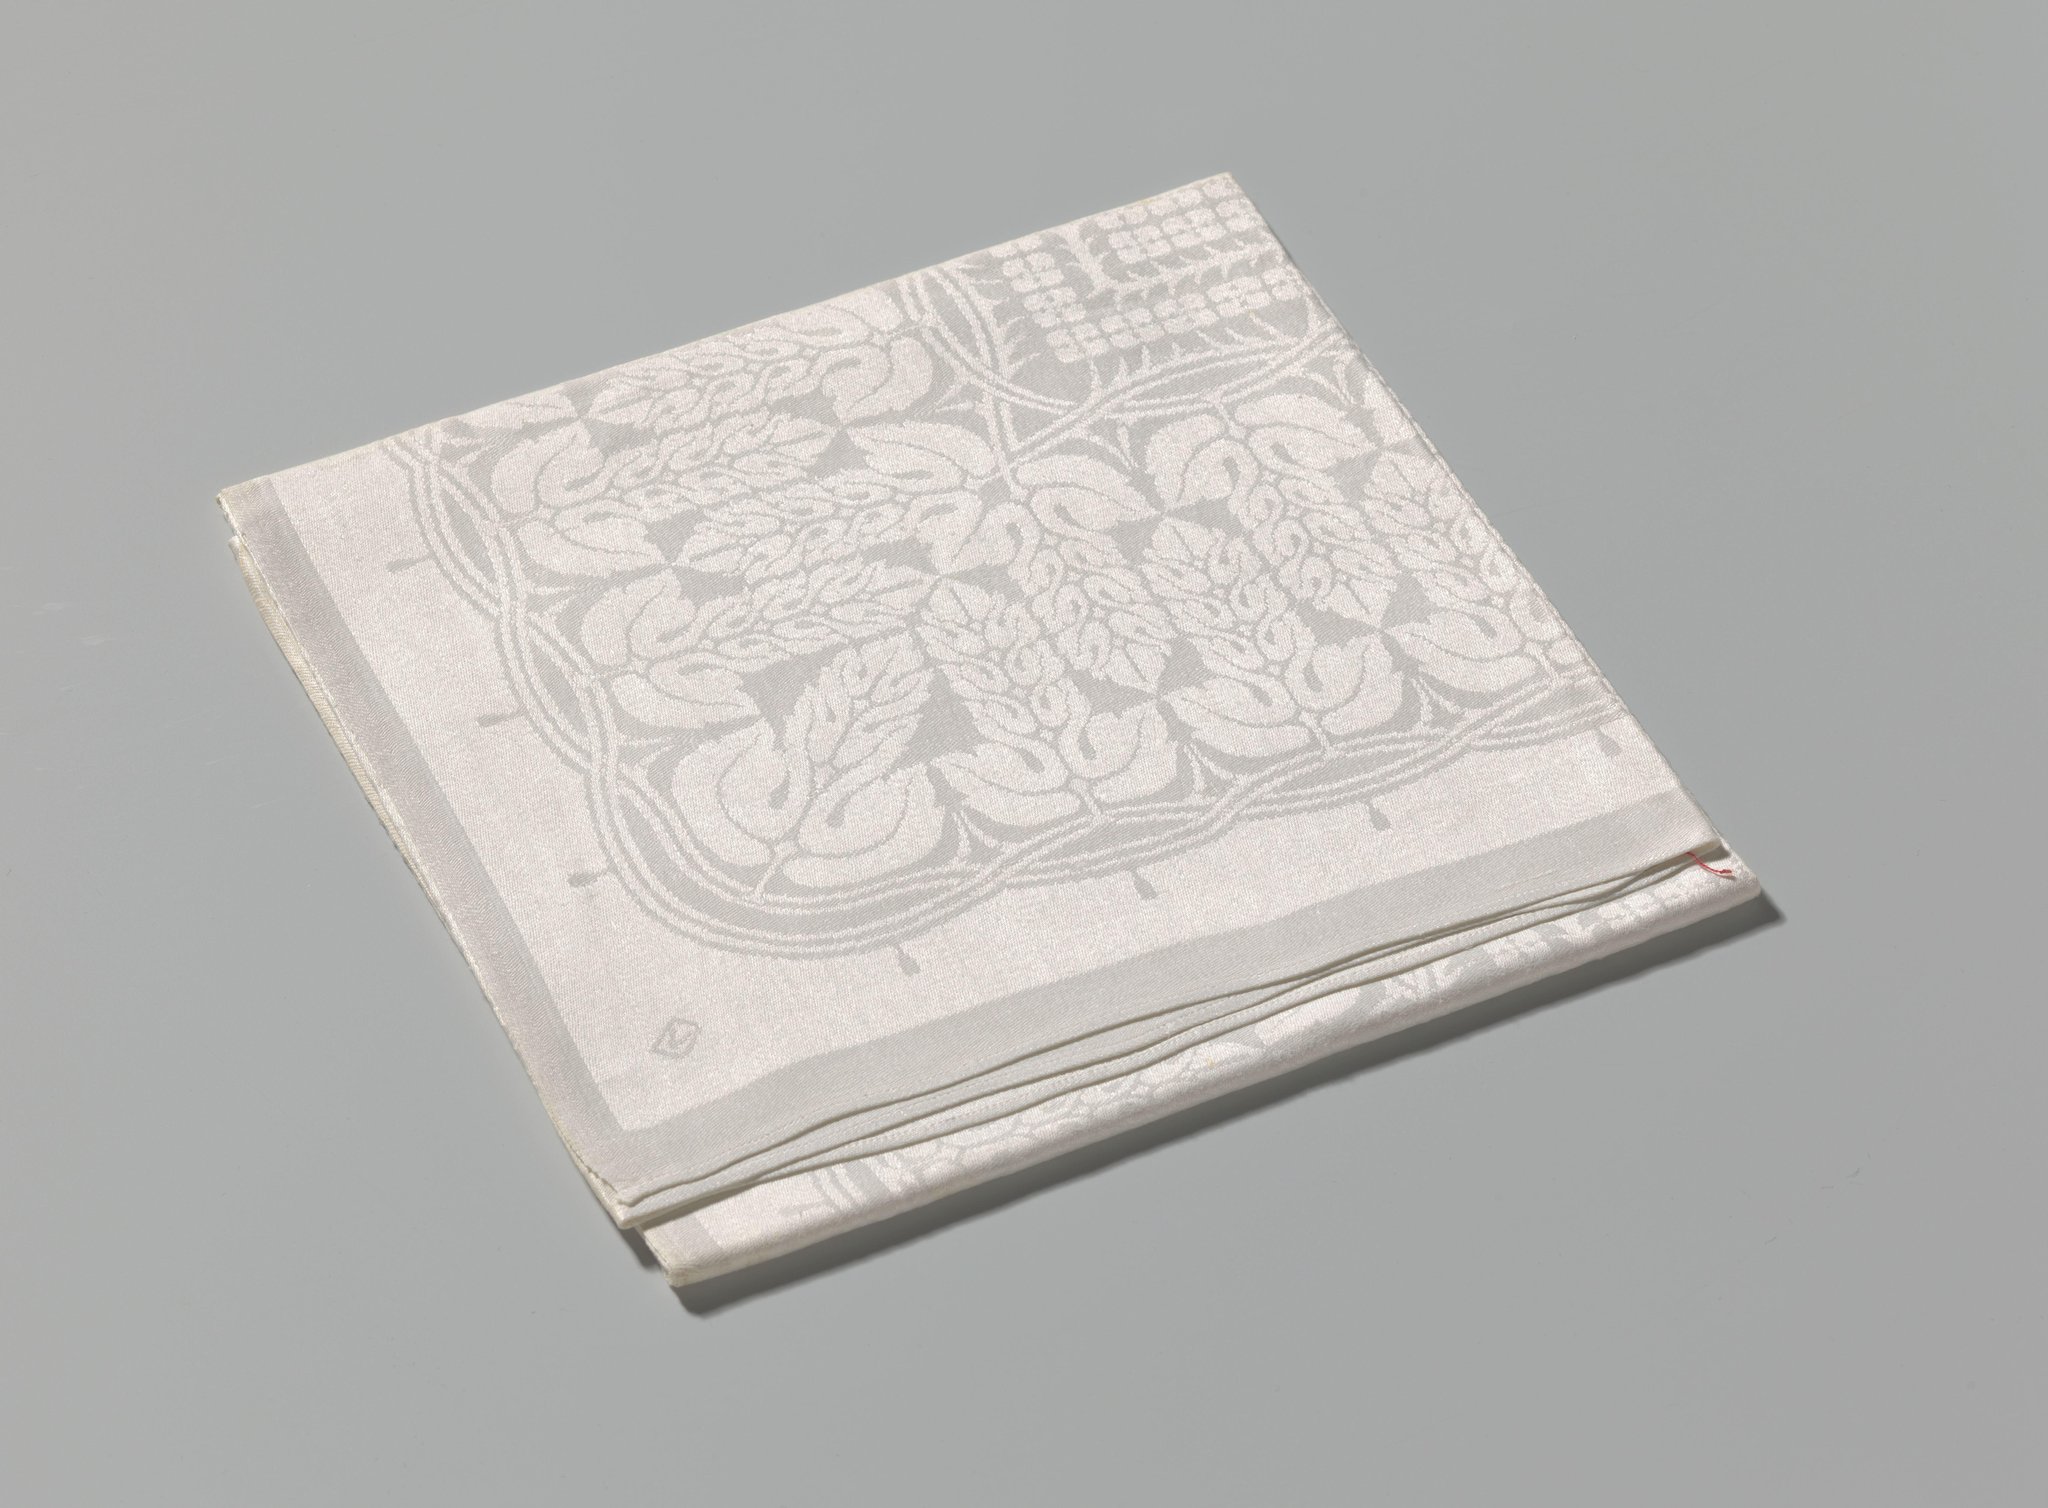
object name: napkin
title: Servet van linnendamast met meidoorns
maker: chris lebeau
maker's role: draughtsman, print maker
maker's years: 1878-1945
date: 1900-1925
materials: linen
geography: eindhoven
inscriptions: mark: ‘TZ’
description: Wit linnen damasten servet met een dessin van meidoorns.